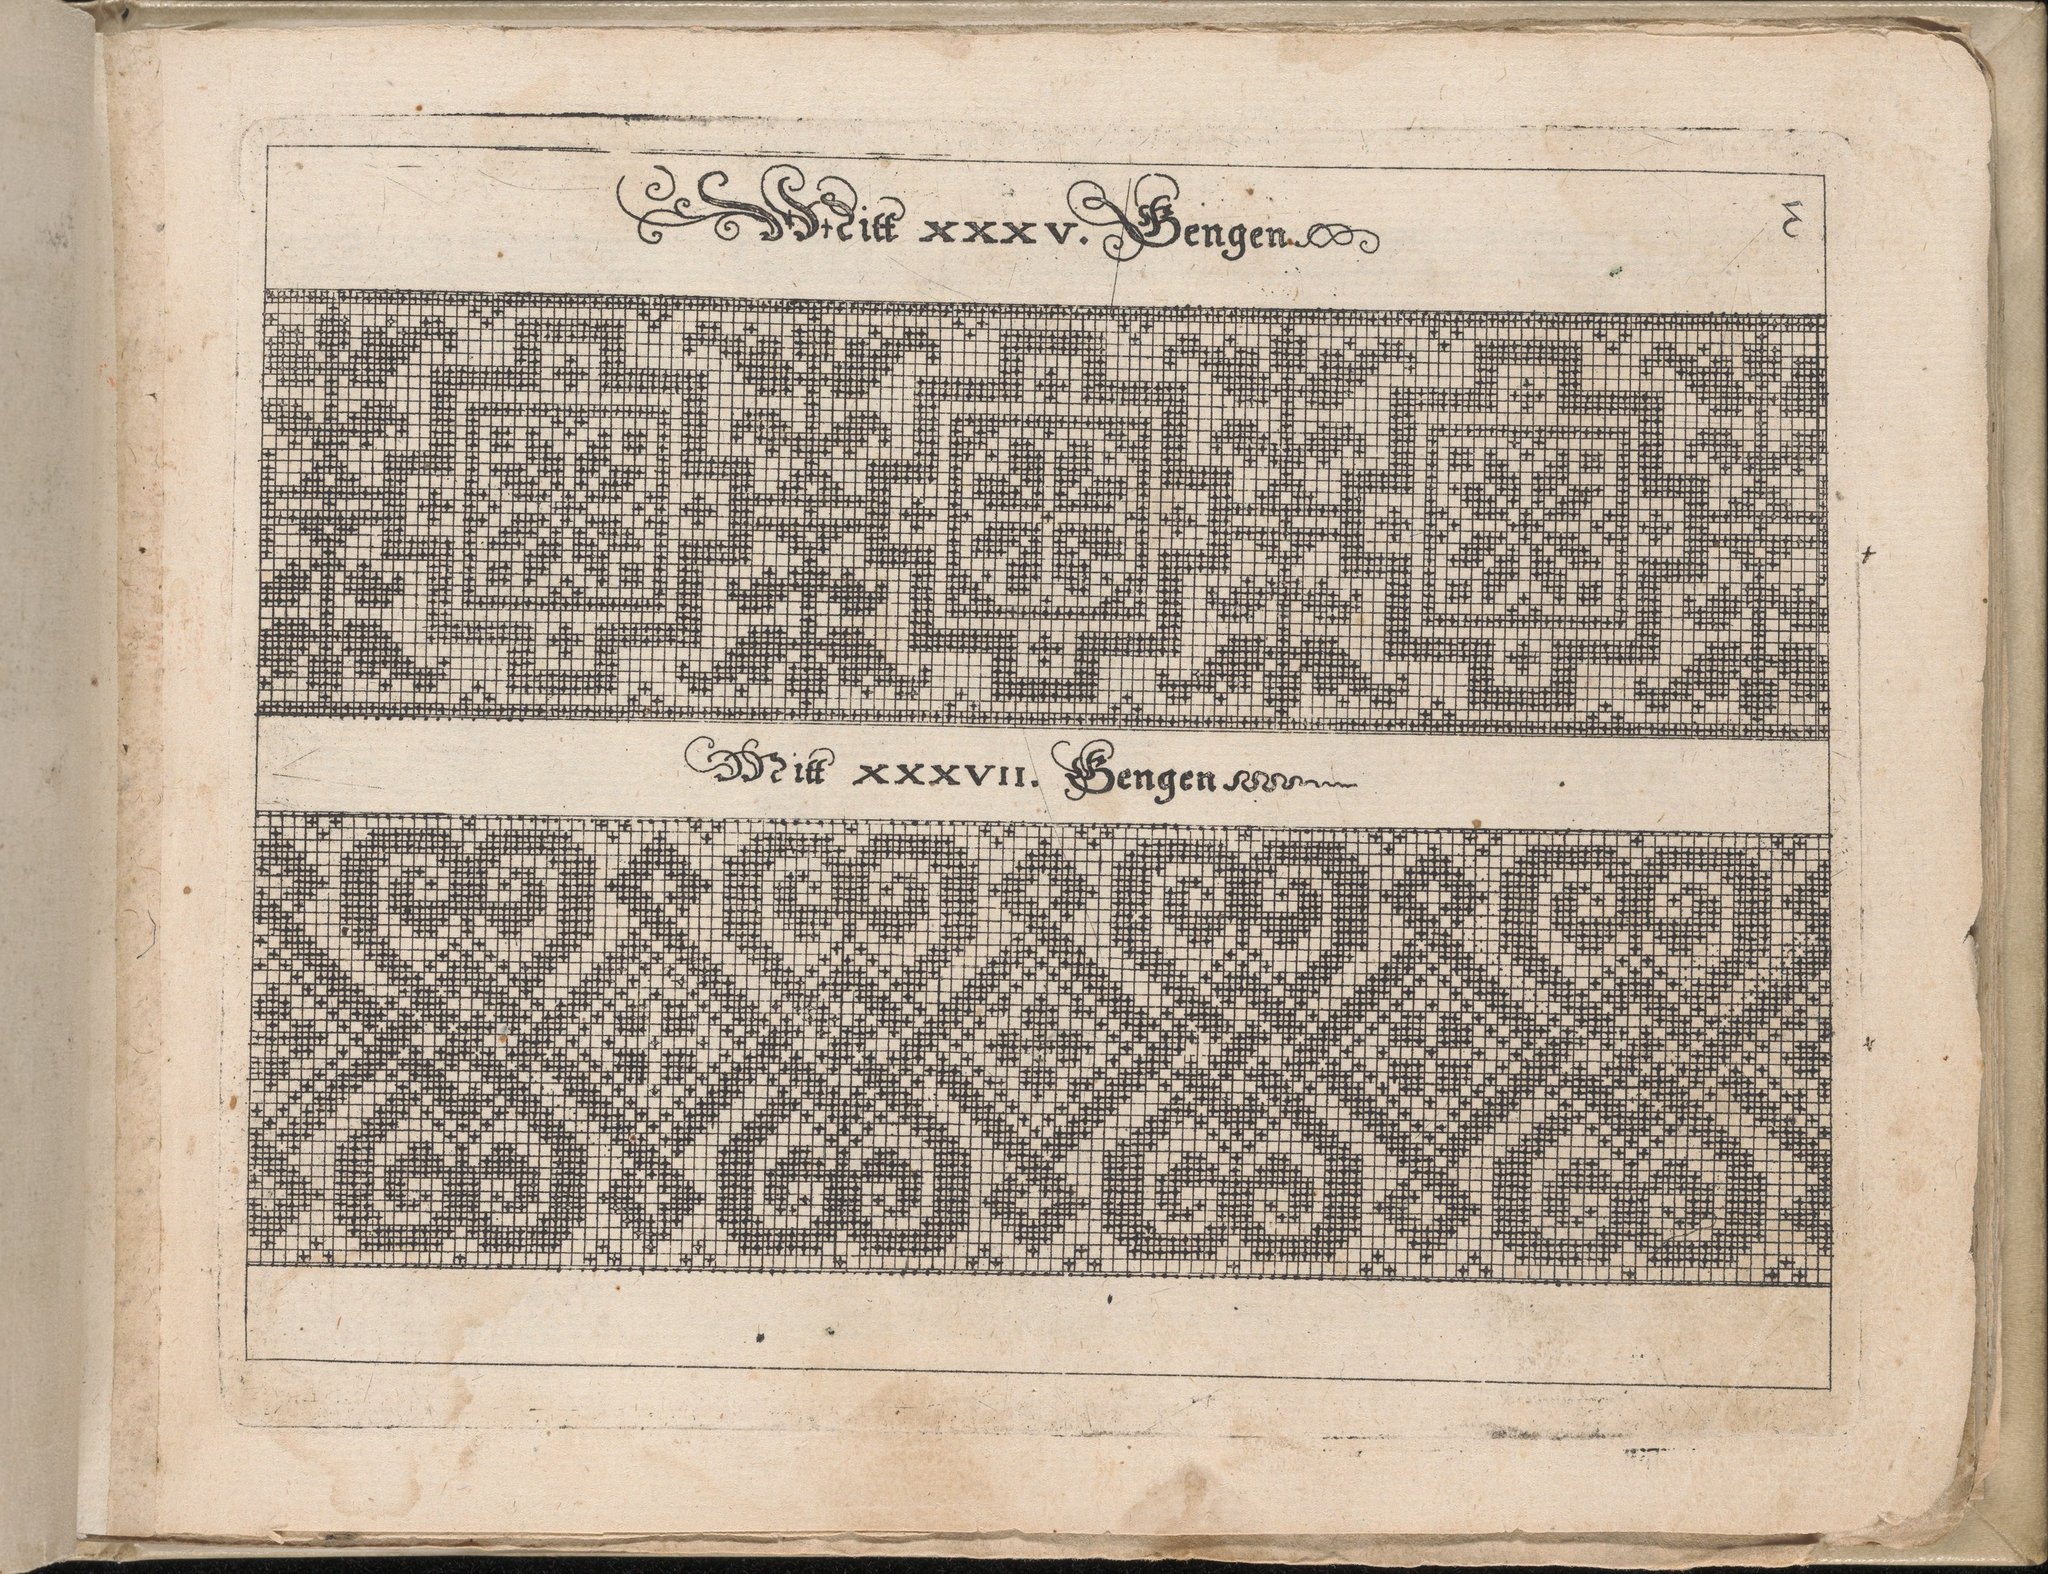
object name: book print ornament architecture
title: Schön Neues Modelbuch (Page 8 recto)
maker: johann sibmacher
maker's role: designer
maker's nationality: german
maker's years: 1590-1611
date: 1597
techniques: etching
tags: ornament